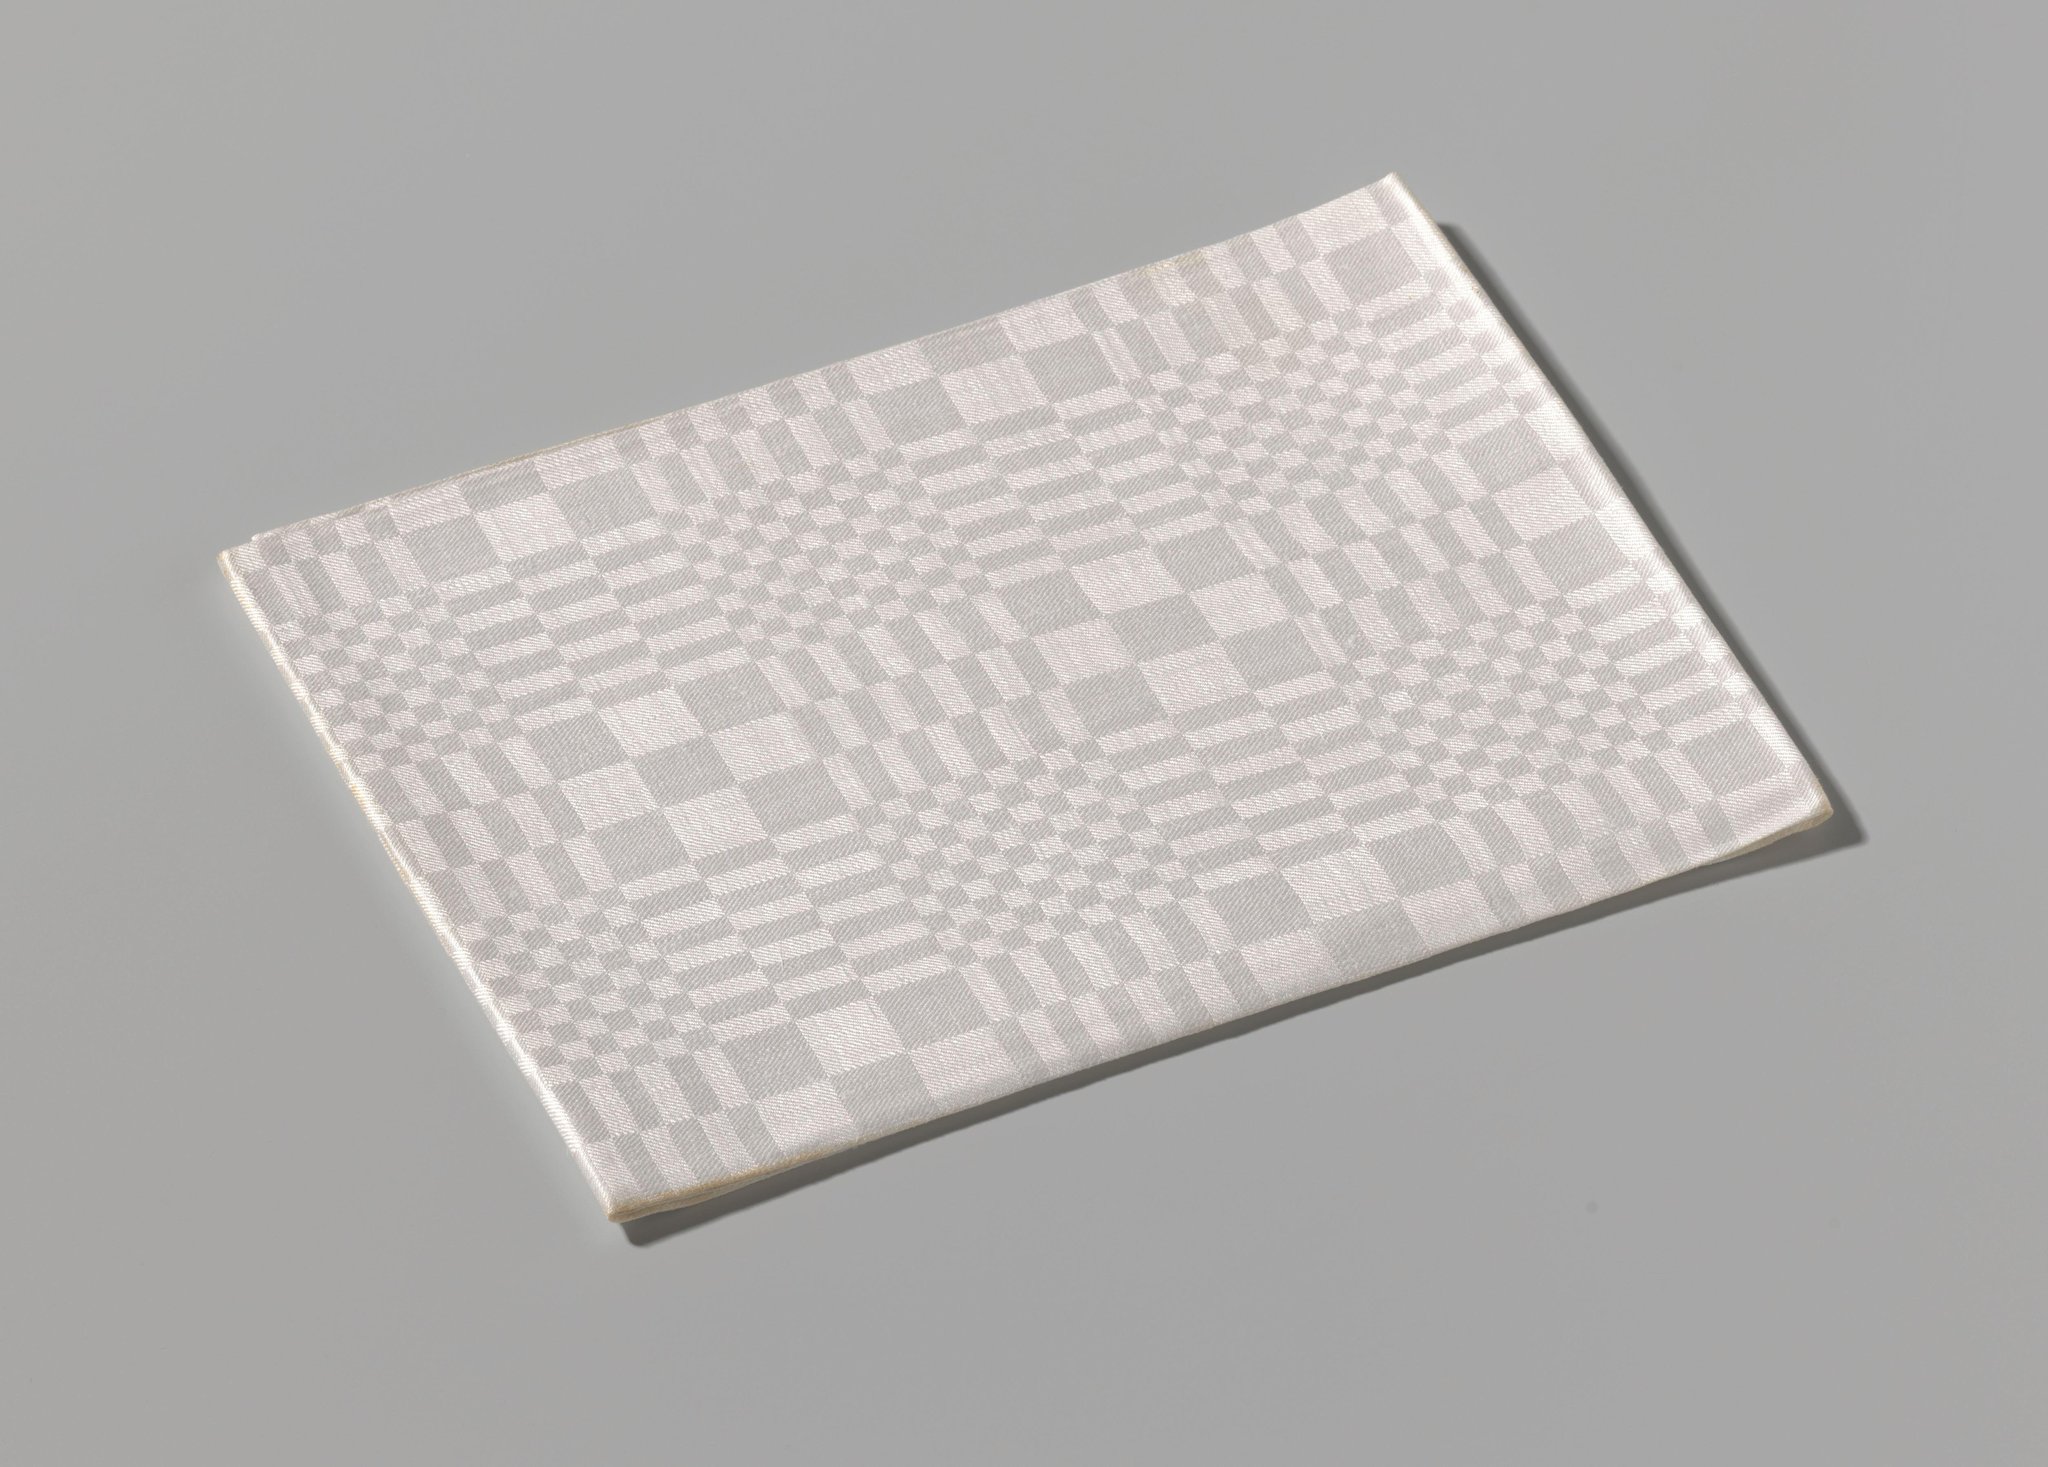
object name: napkin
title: Servet van linnen met pellenpatroon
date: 1784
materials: linen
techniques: twill, peeled fabric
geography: northern netherlands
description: wit linnen servet met pellen patroon, z.g. Engelse garderobe, merk WS 104 en 1784